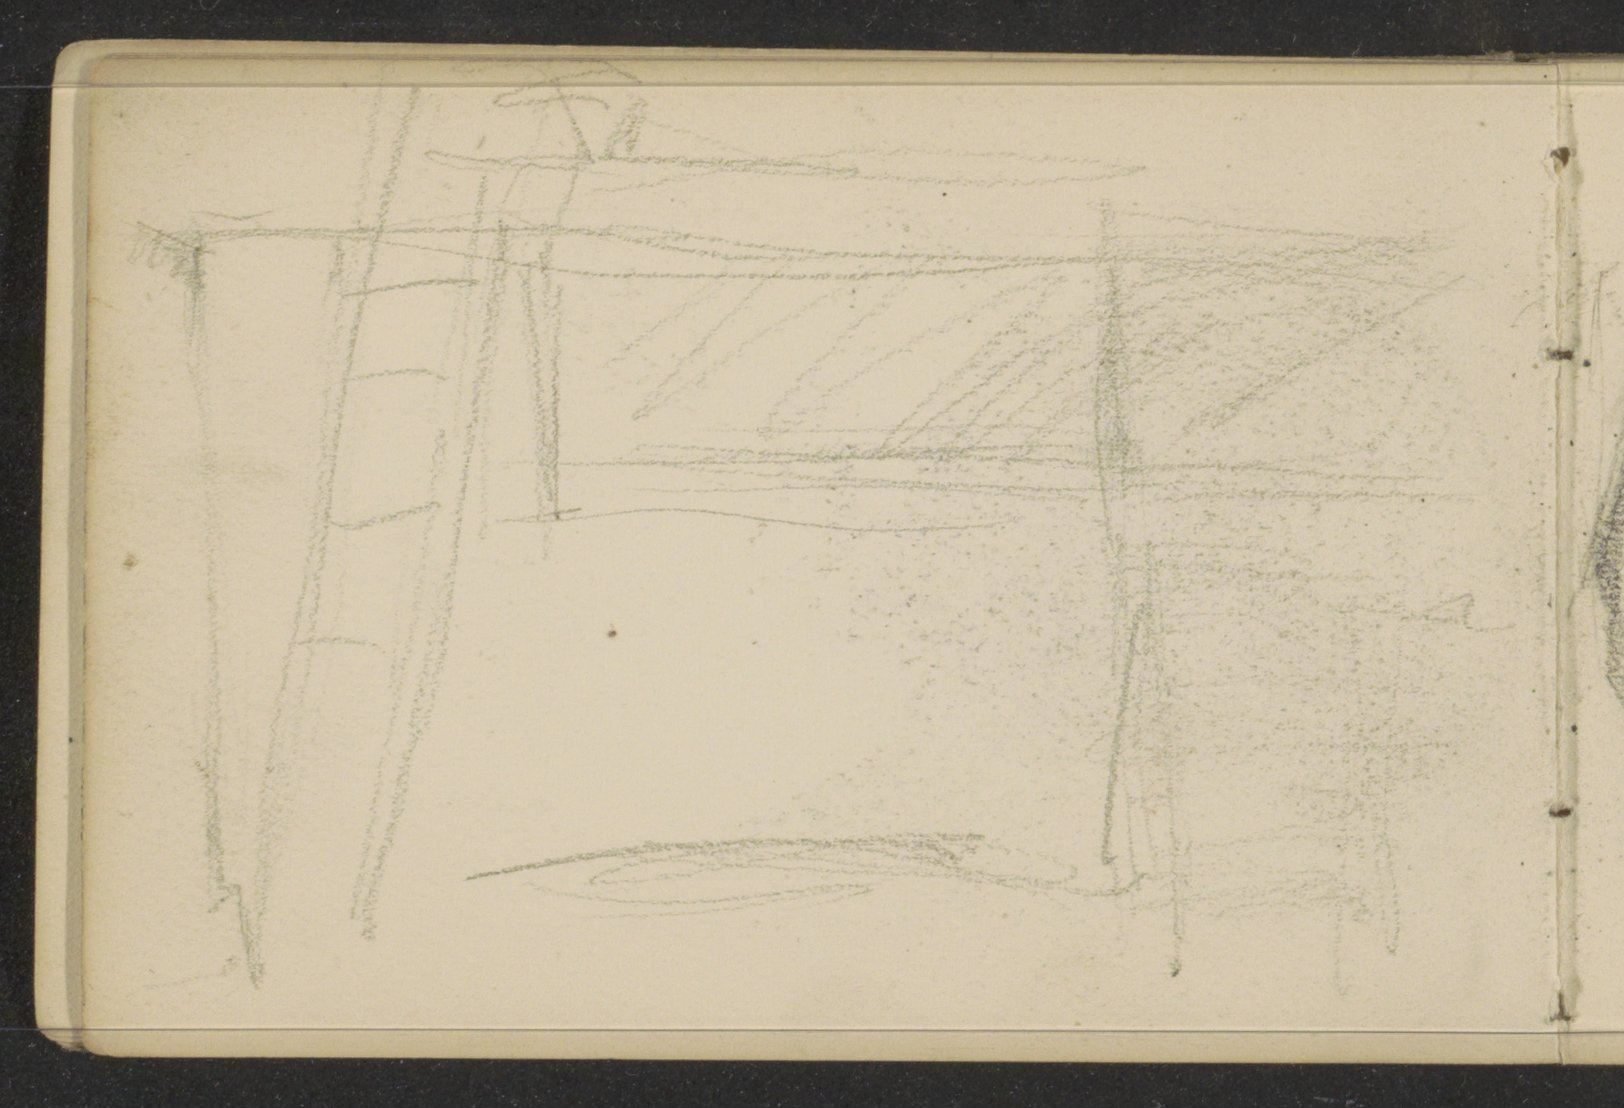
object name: sketchbook leaf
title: Studie, mogelijk architectuur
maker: Anonymous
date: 1880-1900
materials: paper, pencil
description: Blad 6 verso uit een schetsboek met 29 bladen.